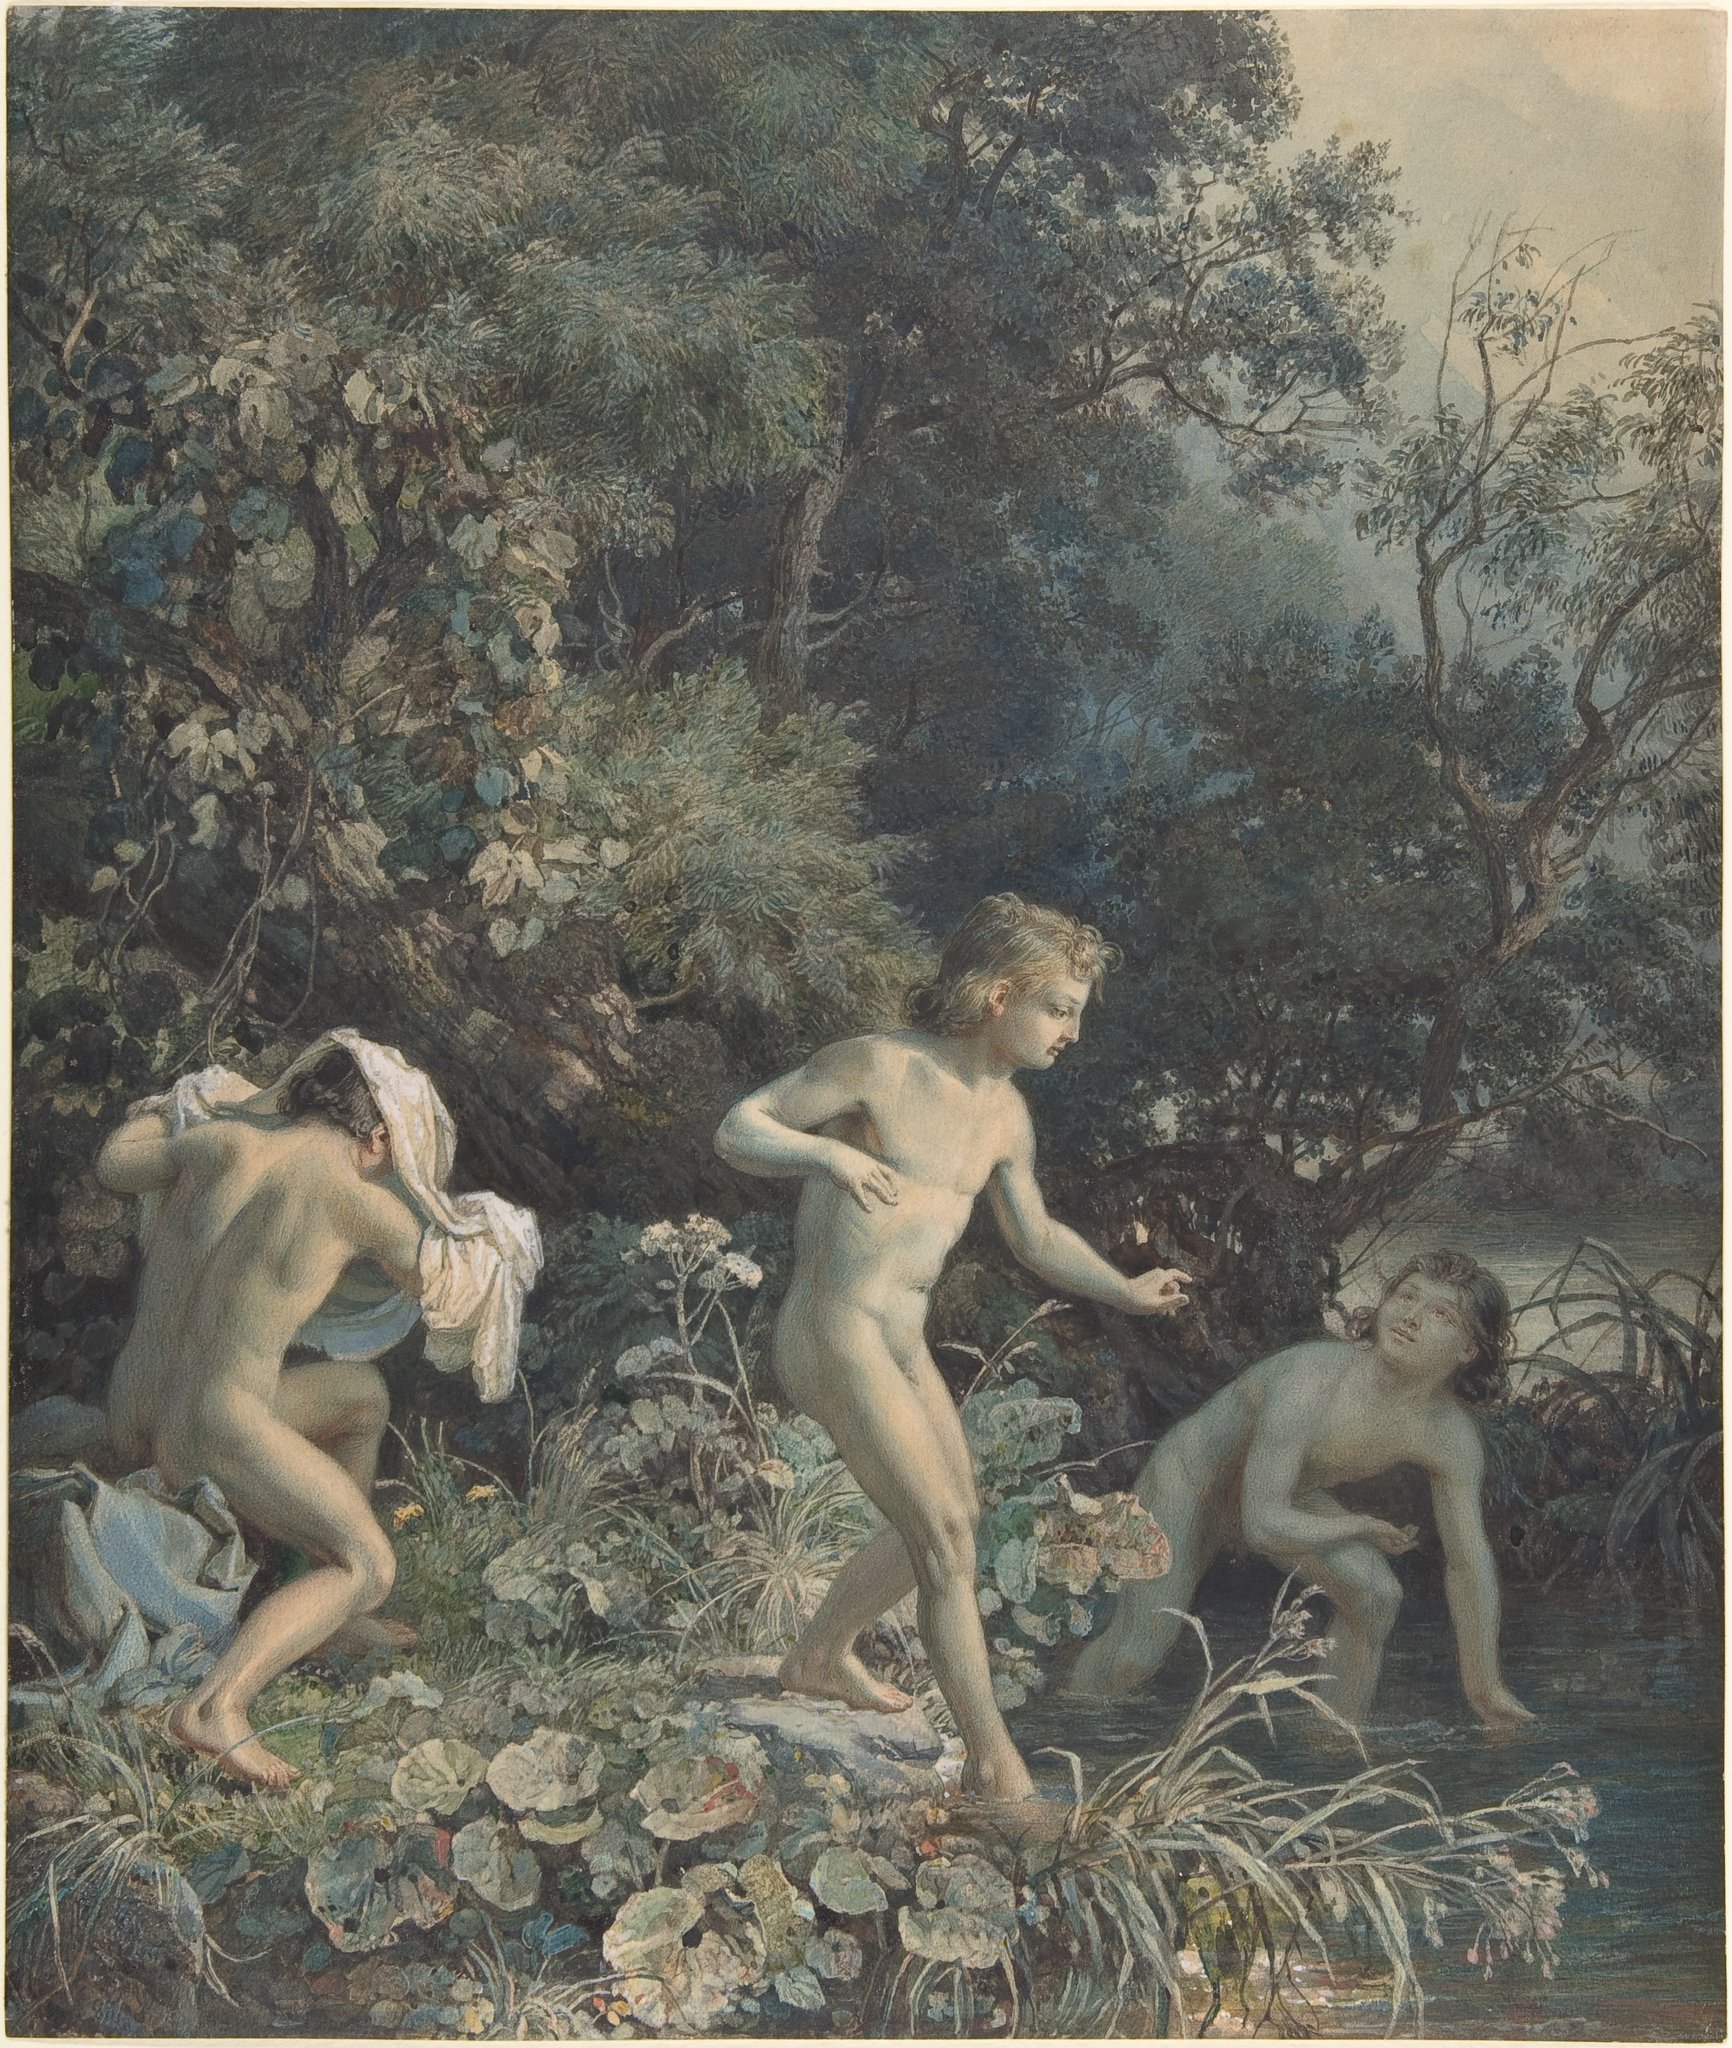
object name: drawing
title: Riverside with Three Bathing Boys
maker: christian friedrich gille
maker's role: artist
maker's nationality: german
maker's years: 1805-1899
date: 1801-1900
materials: paint, watercolor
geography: germany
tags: boys,male nudes,rivers,bathing